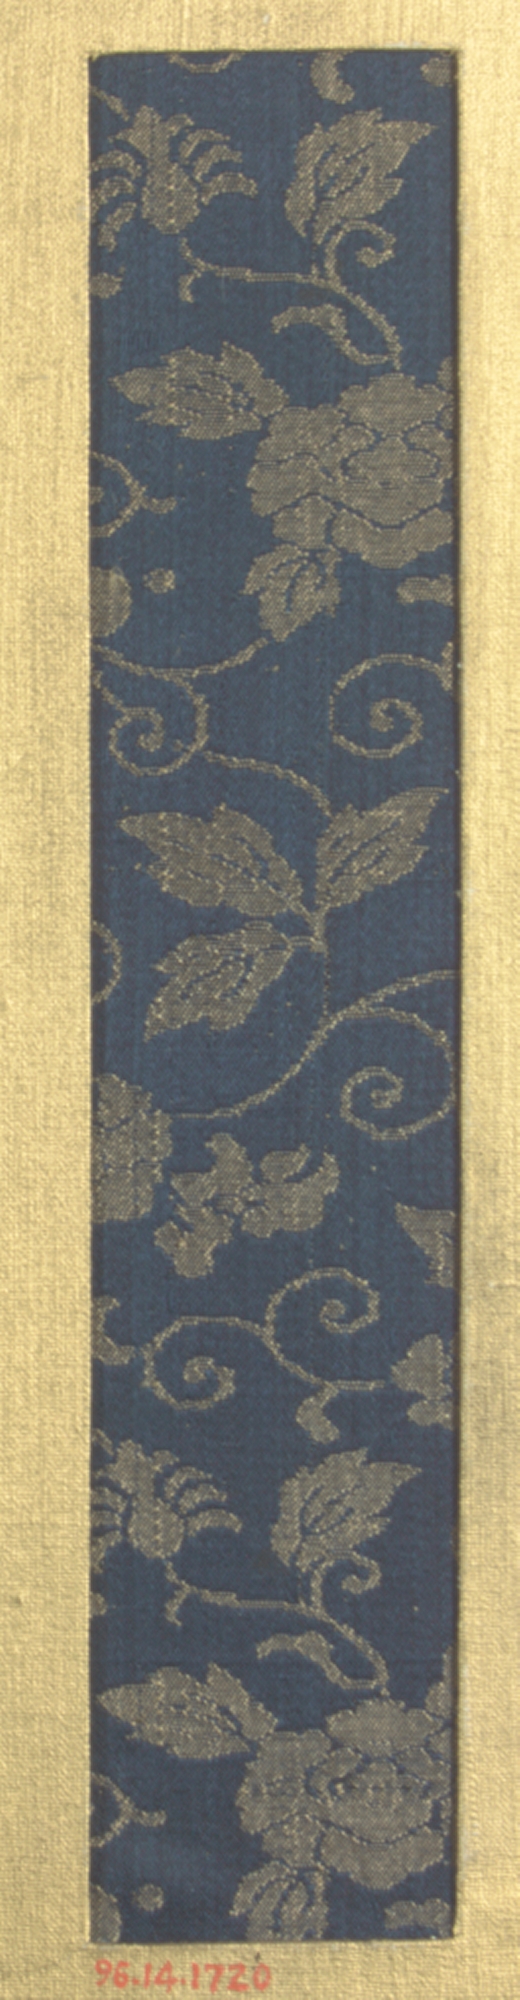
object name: piece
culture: japanese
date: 1701-1900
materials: silk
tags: leaves